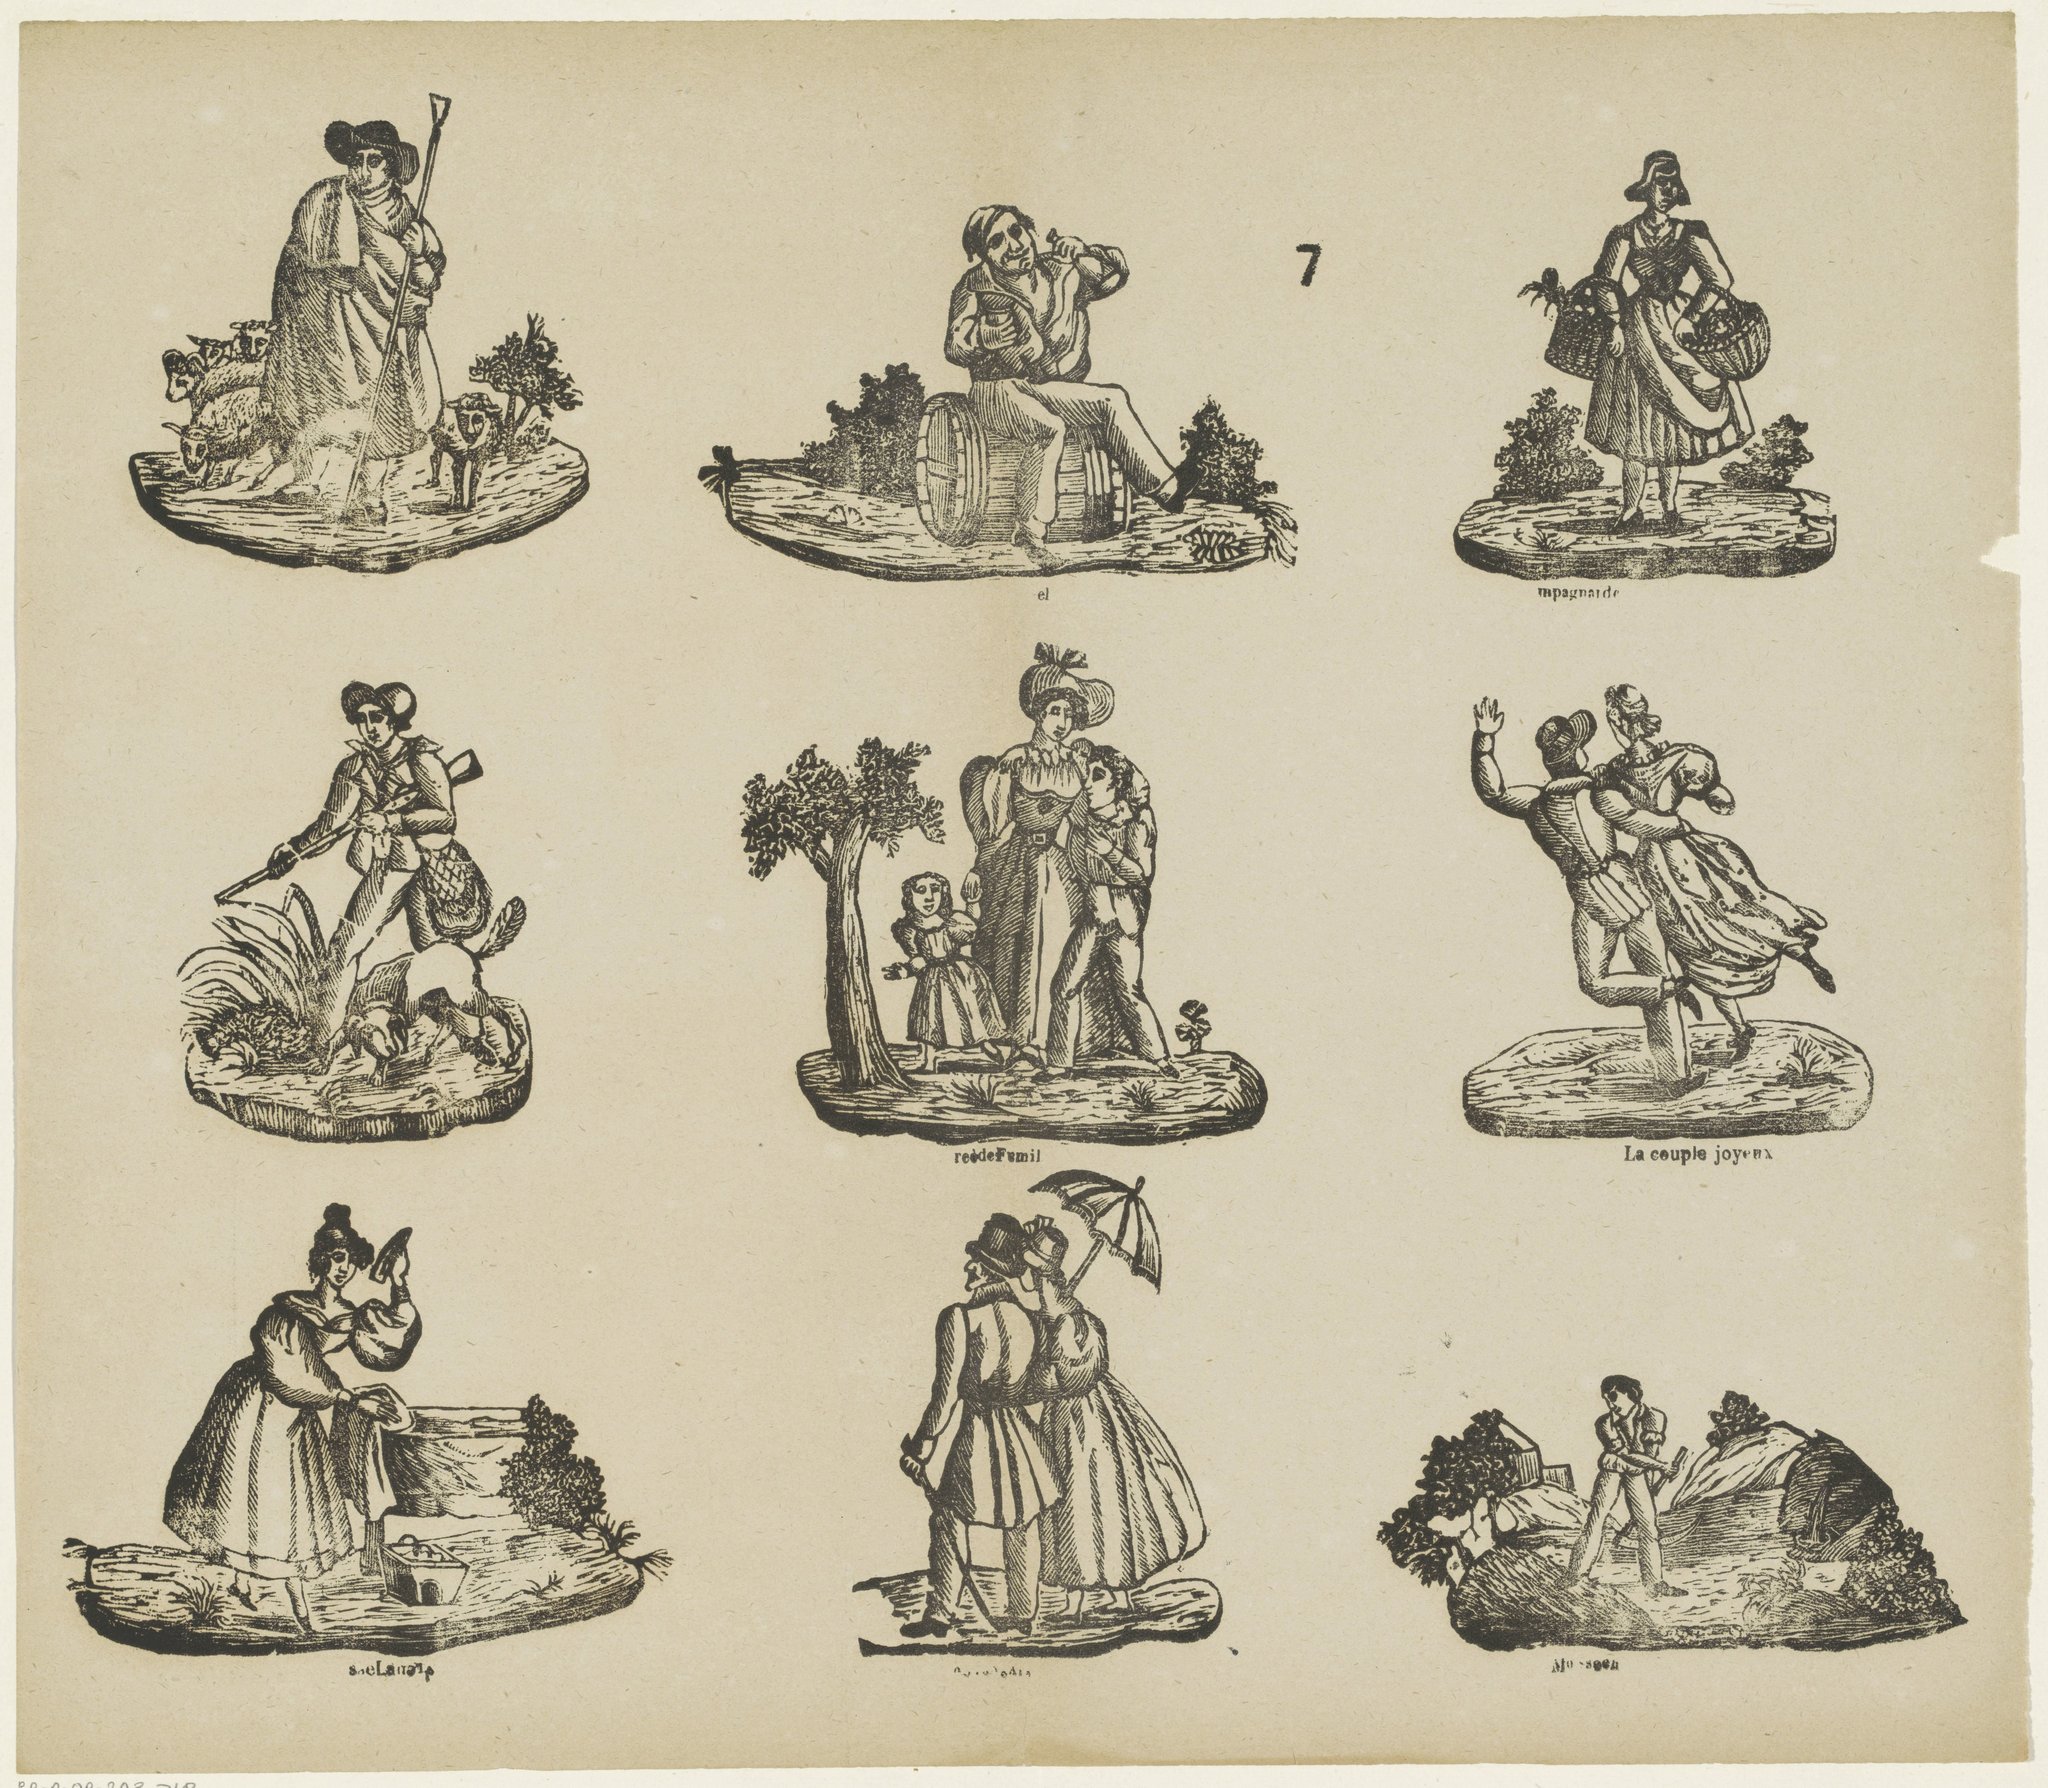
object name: popular print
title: Verschillende figuren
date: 1827-1894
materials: paper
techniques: letterpress printing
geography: schaarbeek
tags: characters (human types)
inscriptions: collector's mark: Lugt 2760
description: Blad met 9 voorstellingen van verschillende figuren, zoals een herder, een vrolijk stelletje en een jager. Onder verschillende afbeeldingen een onderschrift in het Frans. Genummerd midden boven: 7.